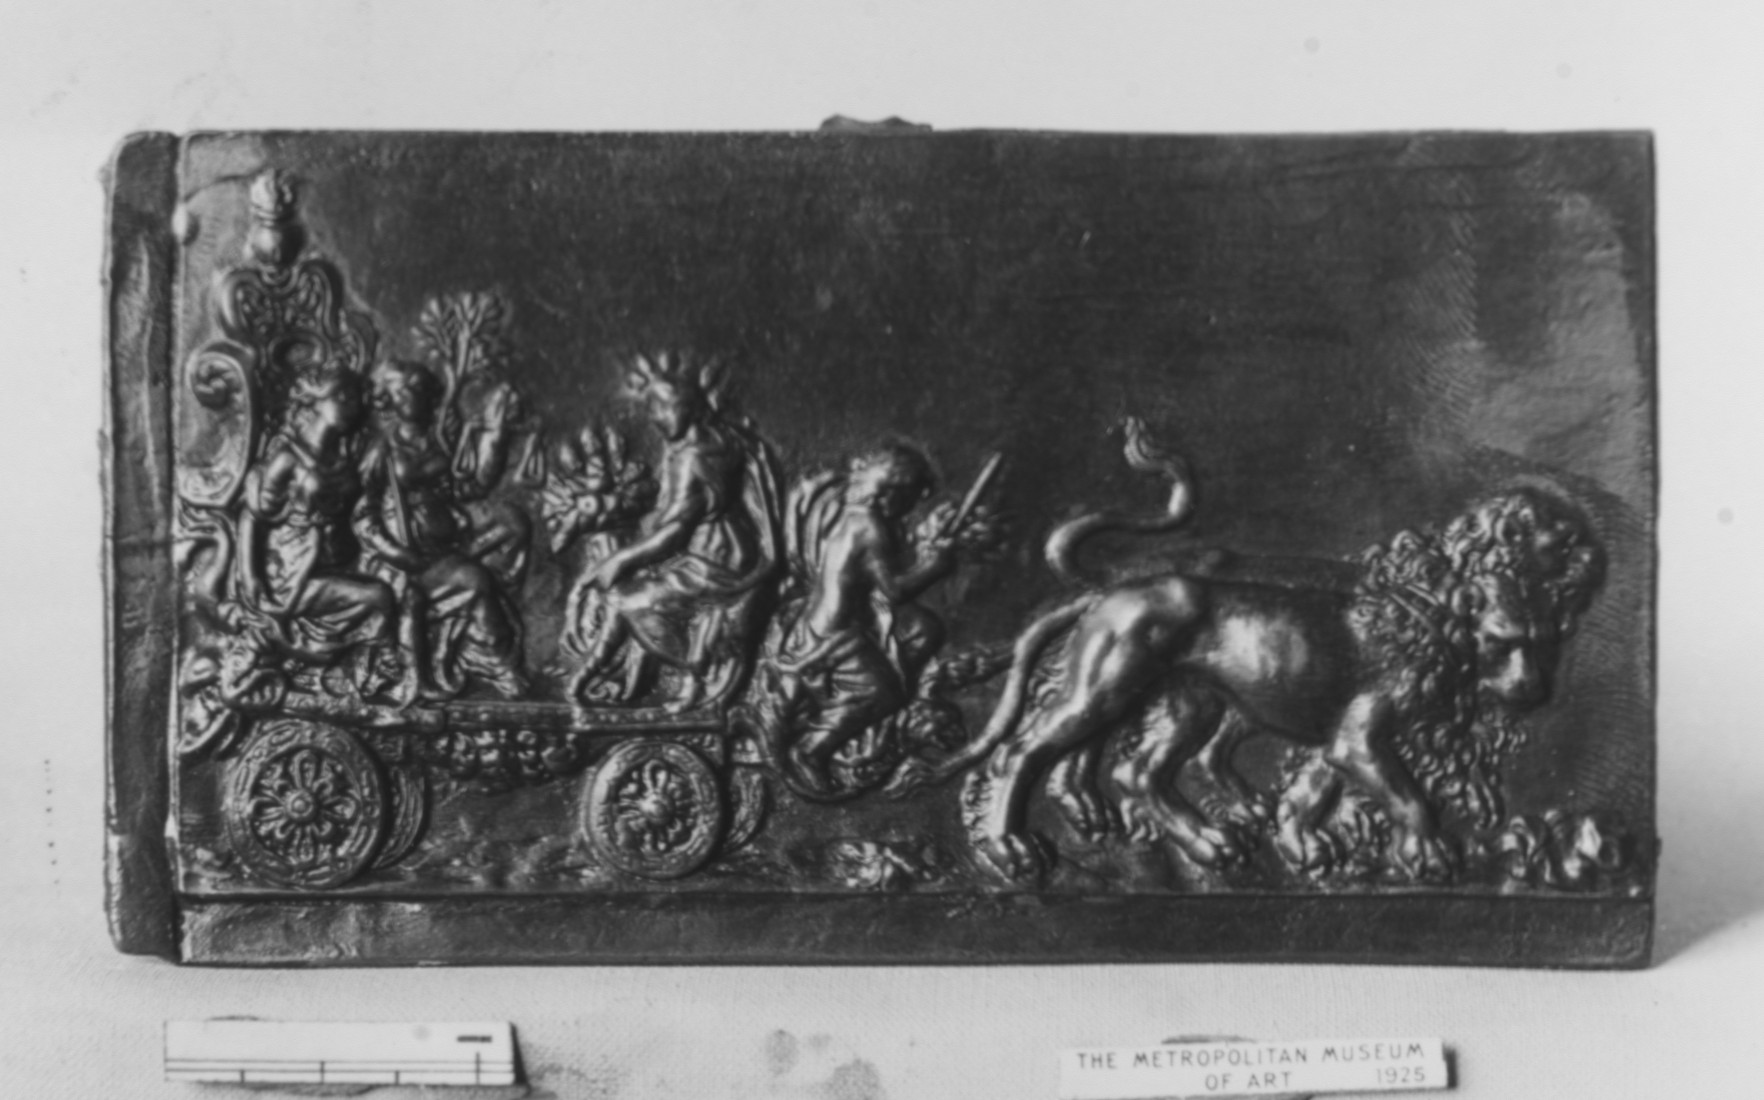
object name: plaquette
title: The Triumph of Virtues: Justice, Peace and Abundance (one of a series)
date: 1576-1600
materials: bronze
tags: men,women,lions,chariots